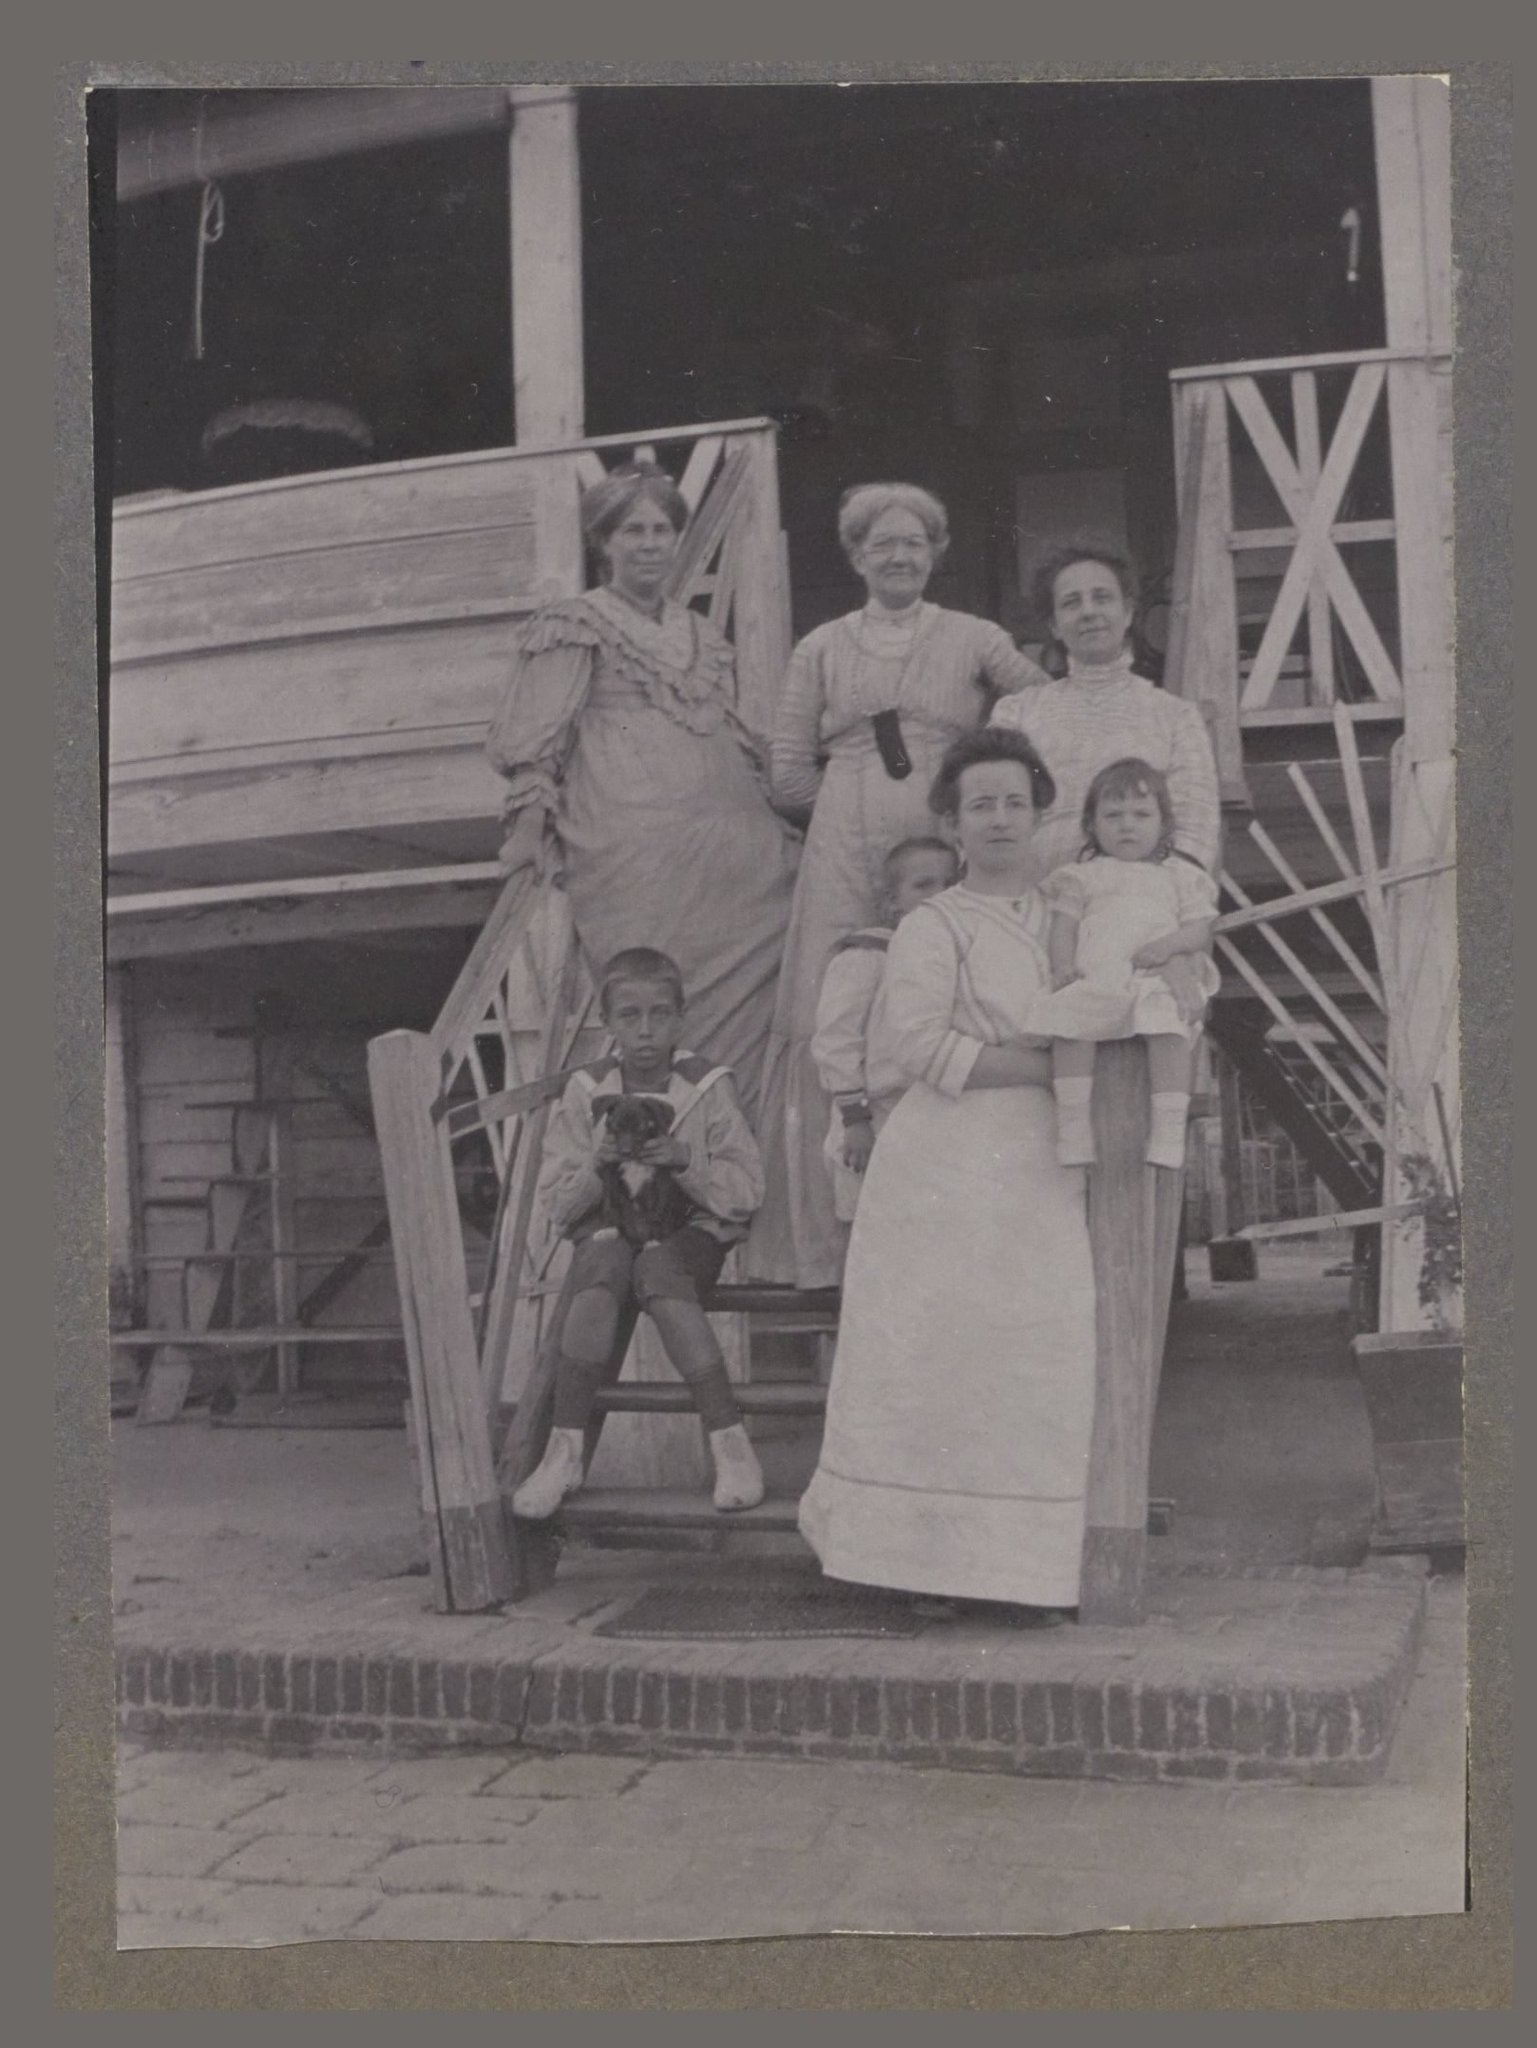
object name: photograph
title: Groepsfoto van vrouwen en kinderen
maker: Anonymous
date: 1912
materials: photographic support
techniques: photography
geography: suriname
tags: plantation, suriname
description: Groepsfoto met vier vrouwen en drie kinderen, staande op de trap van het huis op Plantage Clevia. Rechts met kind op de arm: Anna Rühmann met Lulu (Loulou), de dochter van Maria Gonggrijps zuster. Onderdeel van het fotoalbum over het leven van de familie Gonggrijp in Suriname rond 1912.